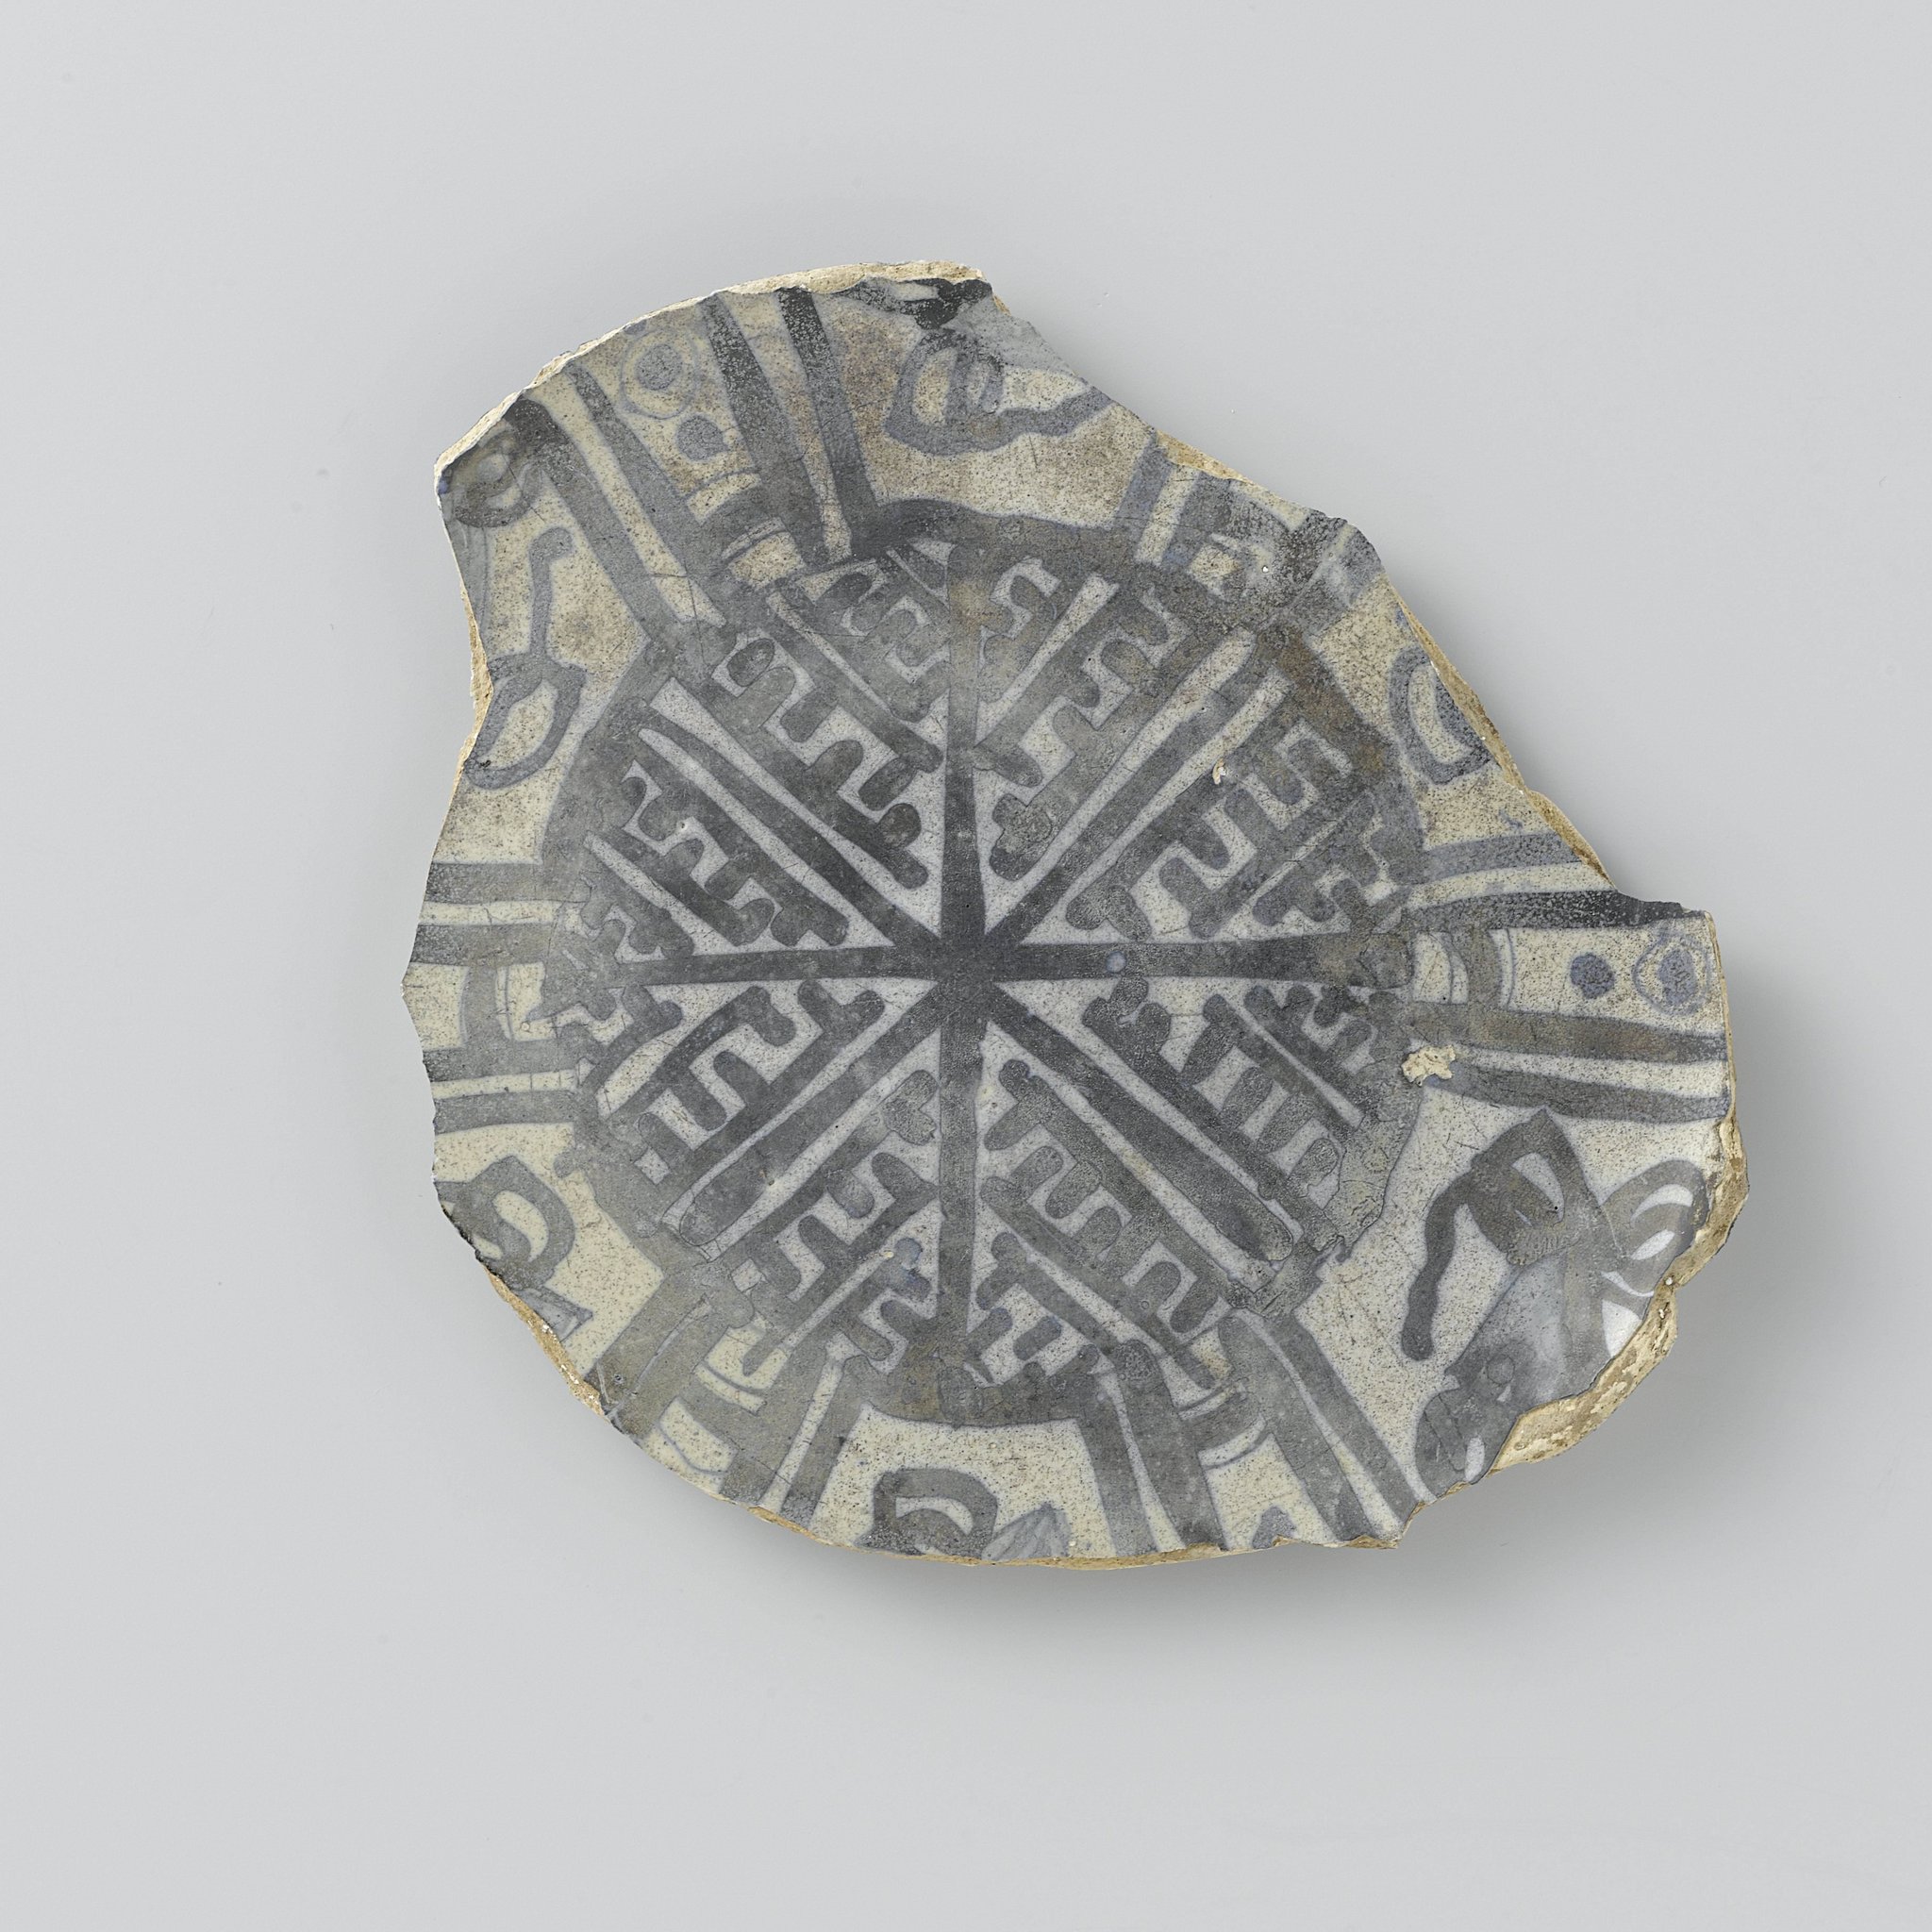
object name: fragment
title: Schotel, fragment, beschilderd met geometrisch motief en Wan-Li rand.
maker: Anonymous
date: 1650-1690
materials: earthenware, glaze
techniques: painted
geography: delft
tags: delft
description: Bodem van een schotel van blauw beschilderde faience, beschilderd met een geometrisch motief op het plat, omgeven door een Wan-Li rand. Het fragment is een bodemvondst uit Delft.